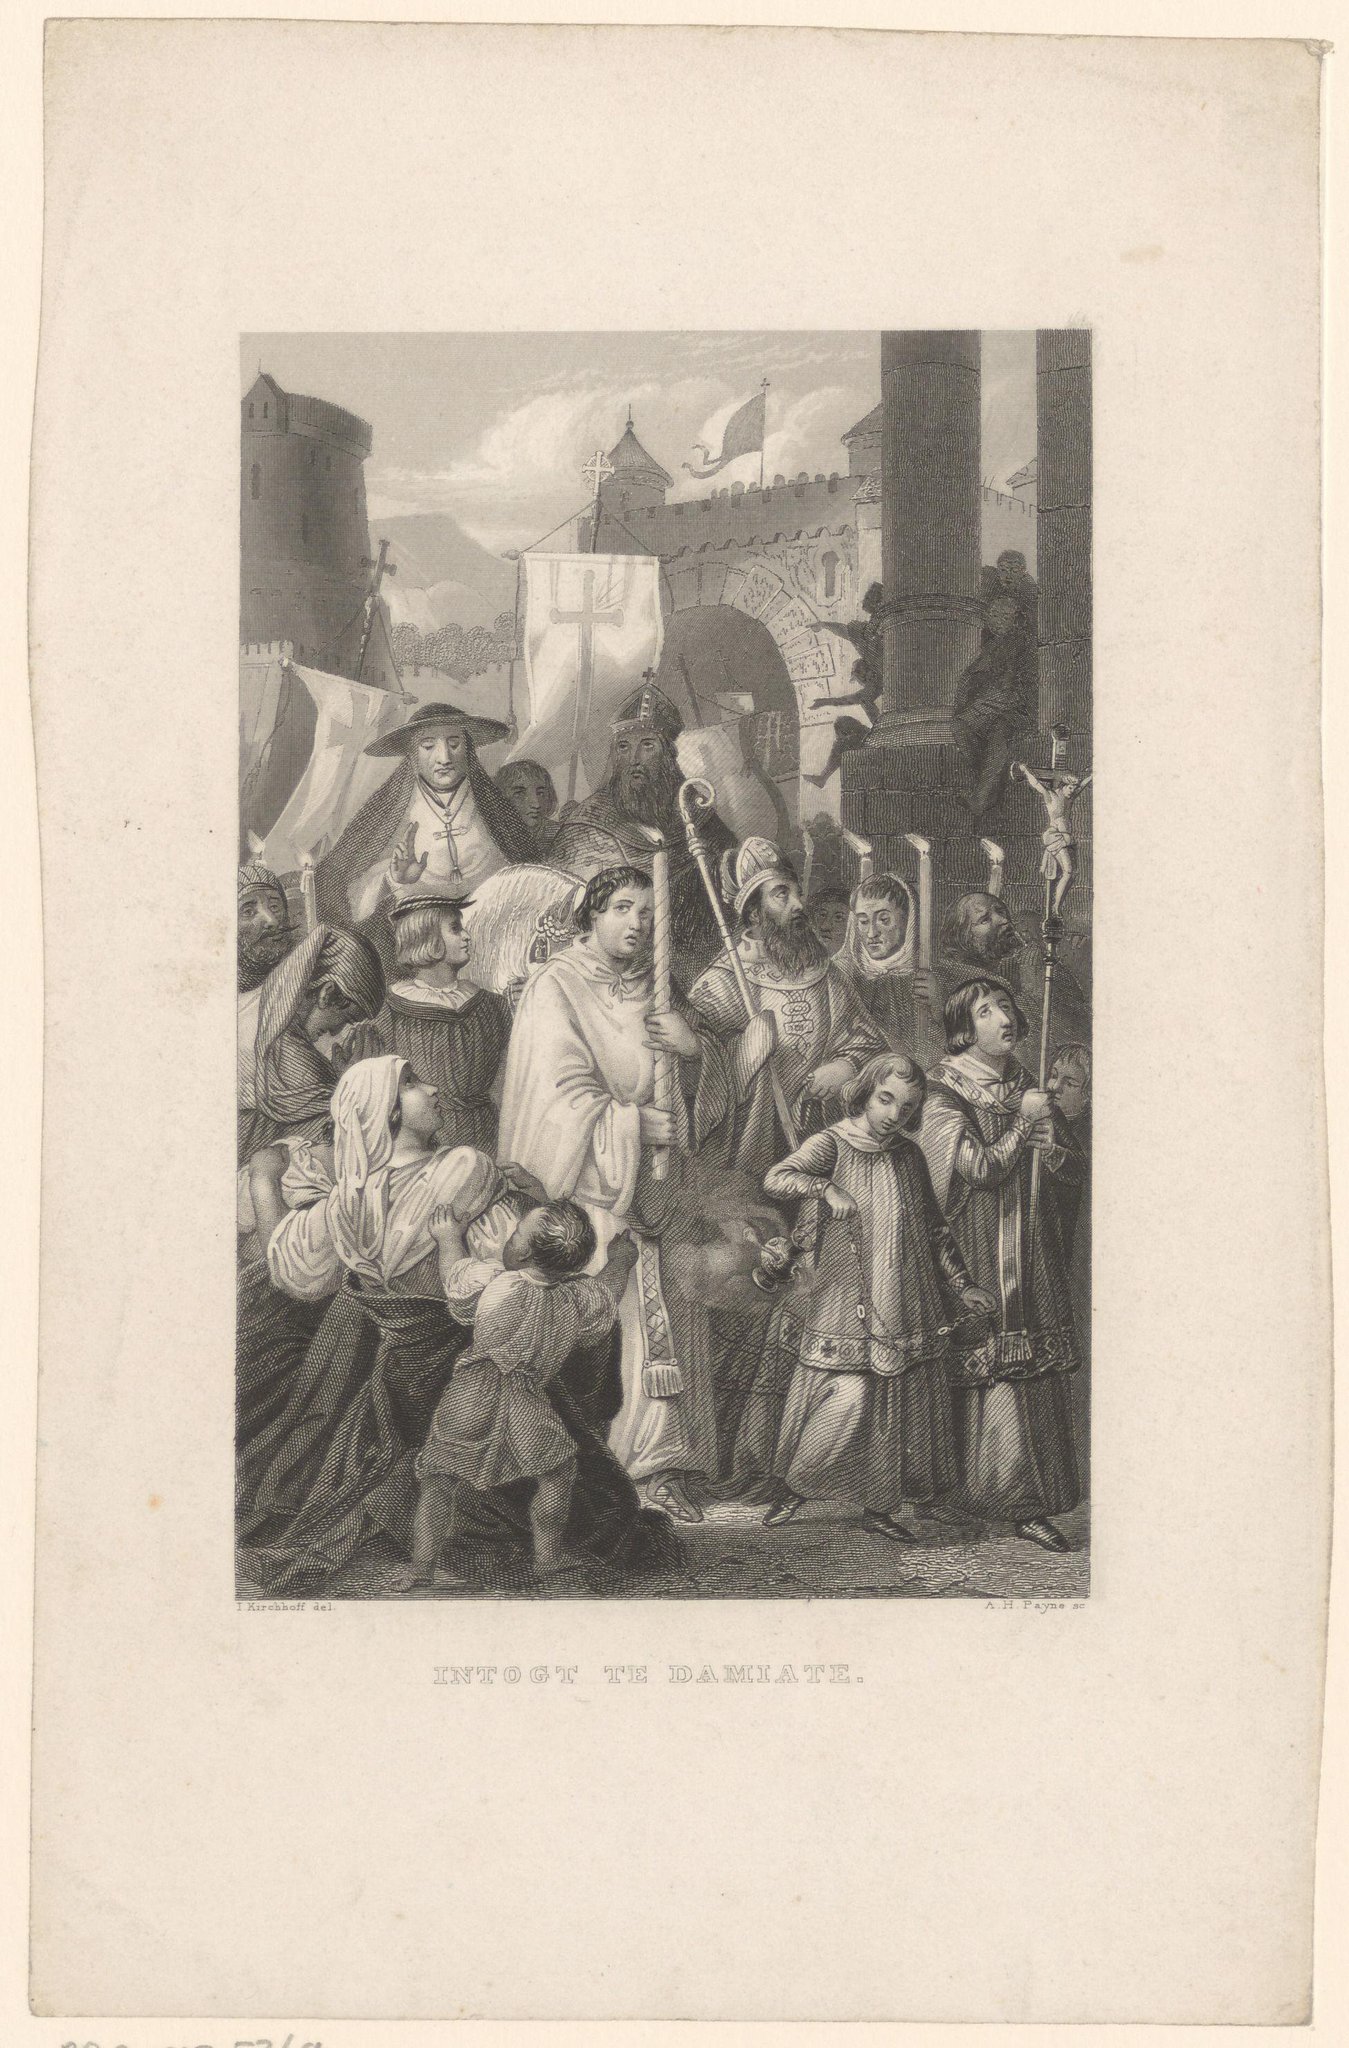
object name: print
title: Intogt te Damiate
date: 1845-1902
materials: paper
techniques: etching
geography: leipzig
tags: st. louis ix on crusade, militant proselytizing: religious war, crusade, etc.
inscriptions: collector's mark: Lugt 2228